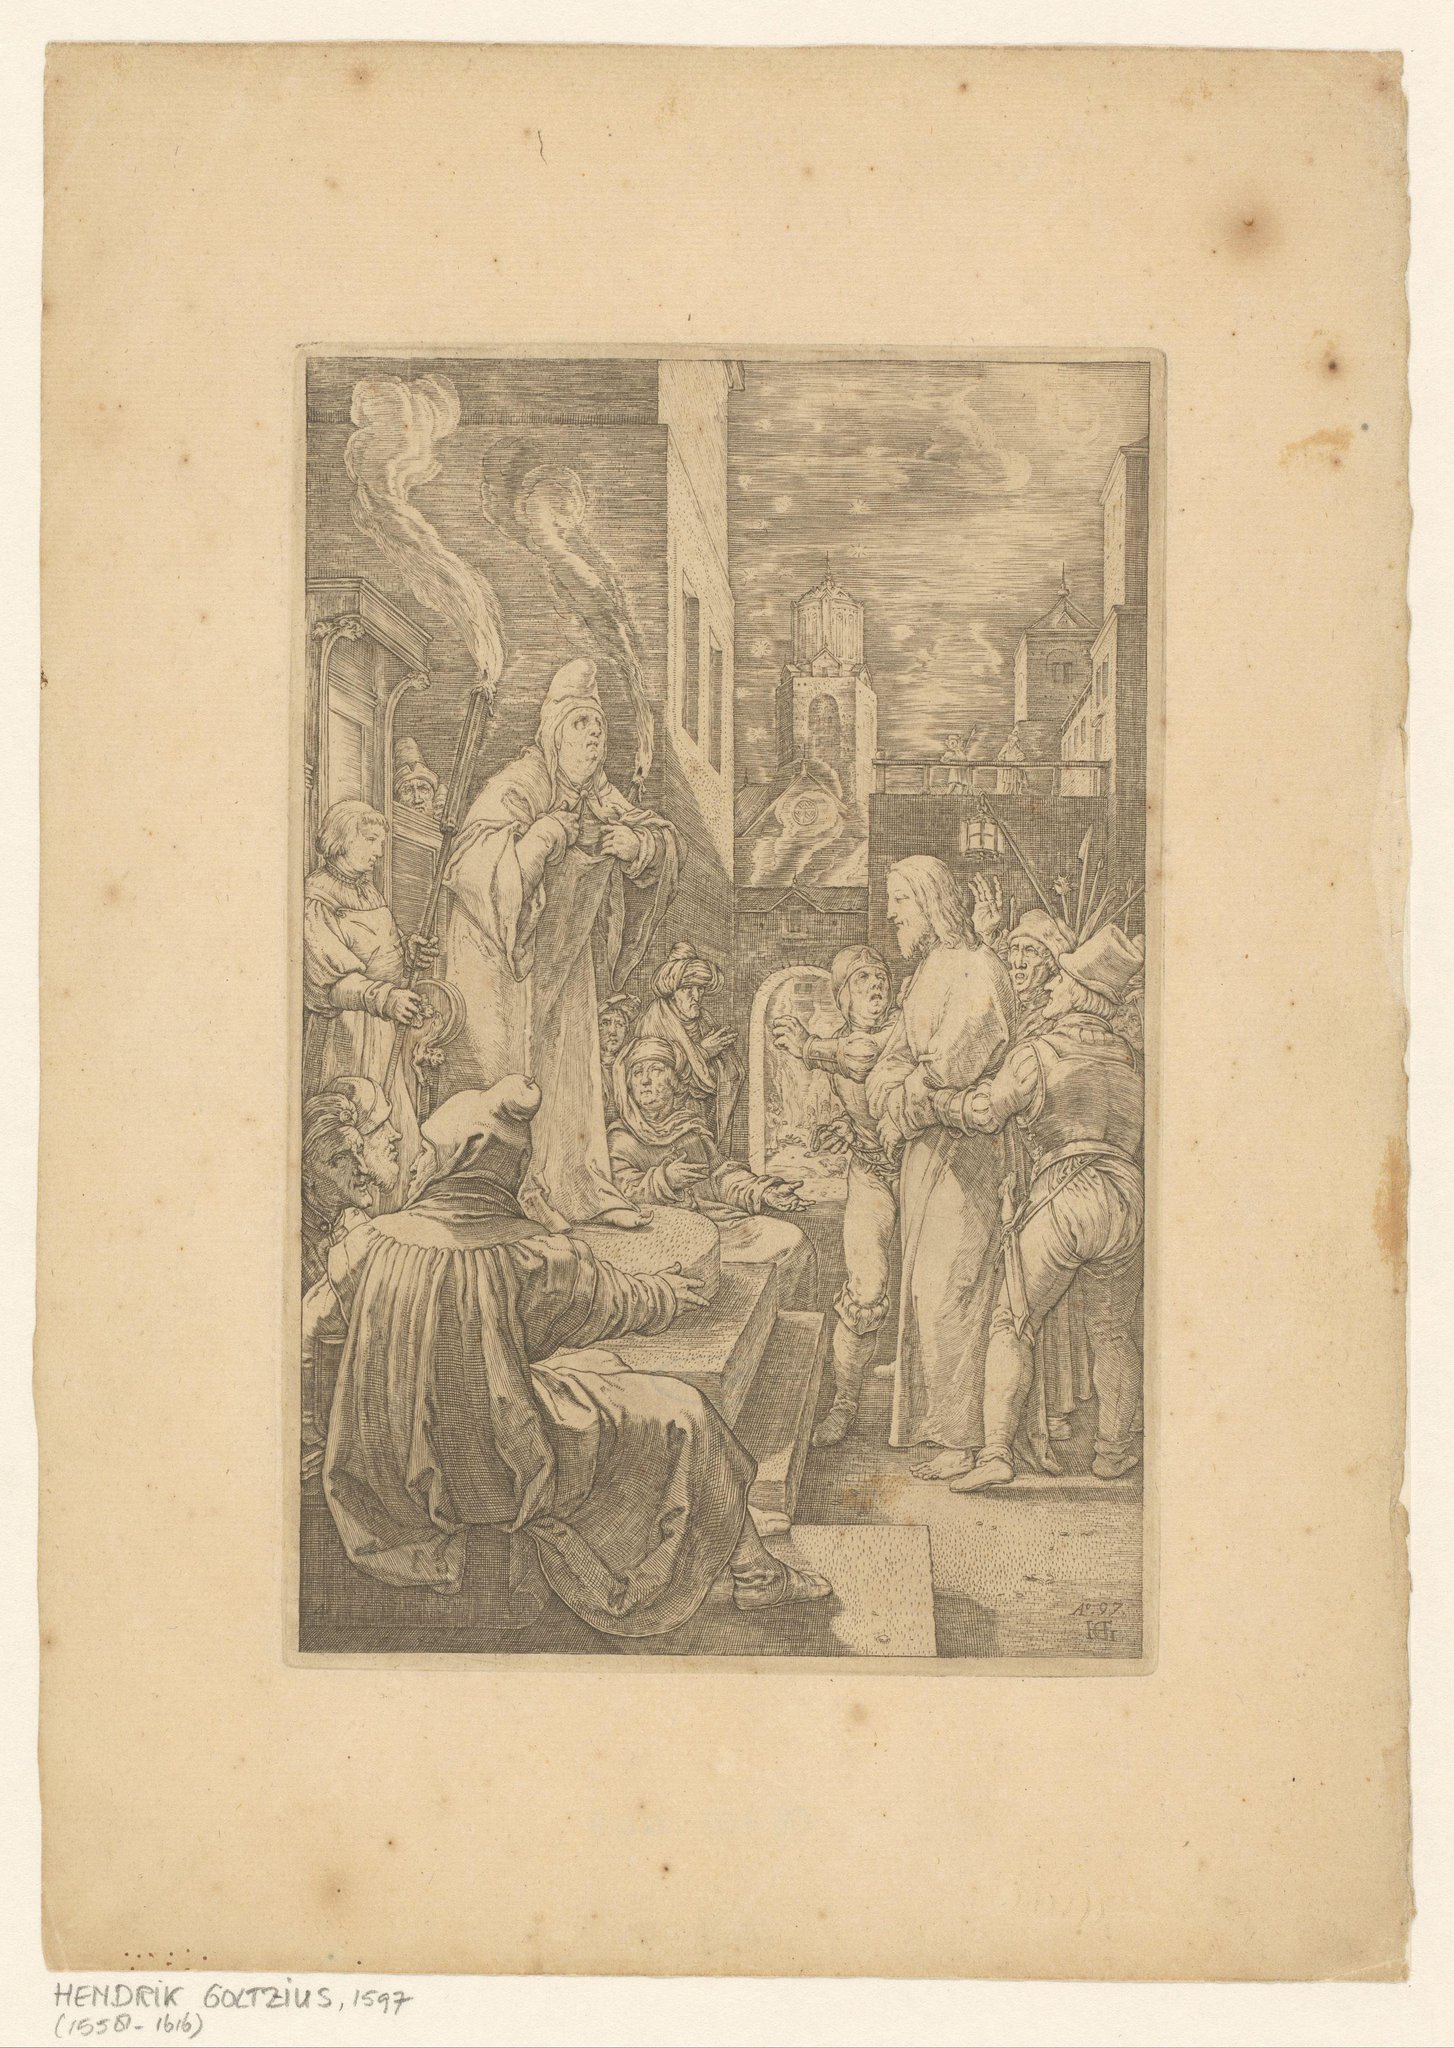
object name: print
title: Passie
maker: hendrick goltzius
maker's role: draughtsman, painter, print maker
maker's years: 1558-1617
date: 1597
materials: paper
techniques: engraving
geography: haarlem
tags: caiaphas tearing his clothes ~ trial of christ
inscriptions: collector's mark: Lugt 2228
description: De twaalf bladen van deze serie zijn gegraveerd in de stijl van Lucas van Leyden, maar ook komen delen van de composities overeen met gedeeltes van Dürers Passie. Er bevindt zich een ongedateerde tekening die gediend heeft als model voor de prent in het Museum für Bildende Kunst in Leipzig (afgebeeld in Reznicek, zie literatuur).